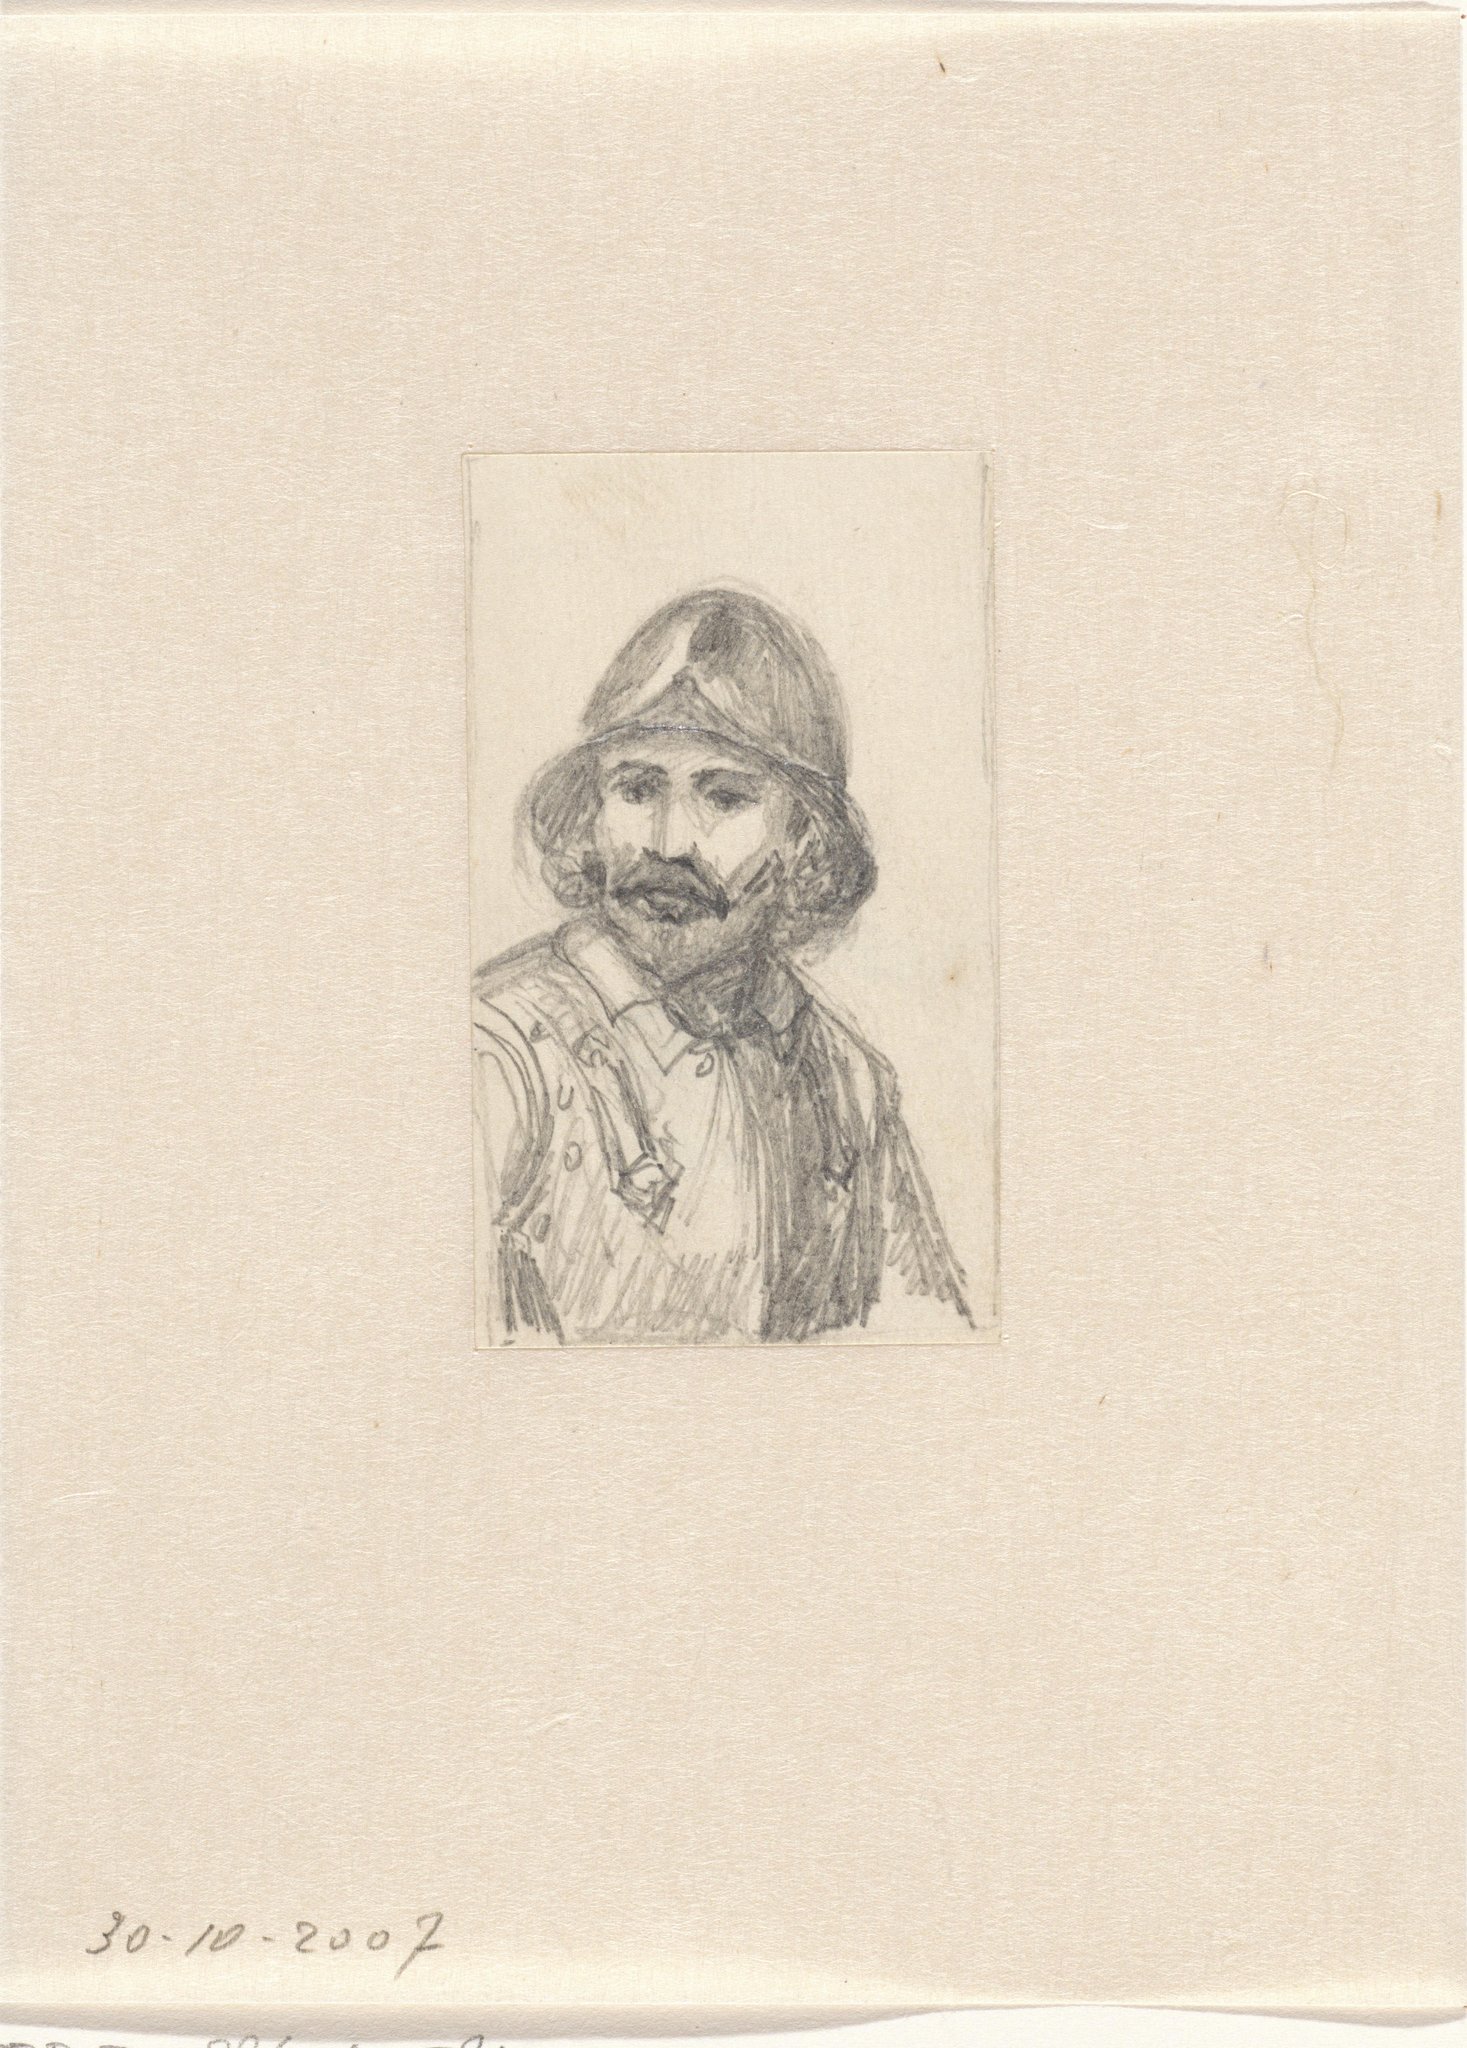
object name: drawing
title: Buste van een krijgsman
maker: christiaan wilhelmus moorrees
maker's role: draughtsman, print maker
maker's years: 1801-1867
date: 1811-1867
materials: paper, pencil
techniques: pouncing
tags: officer